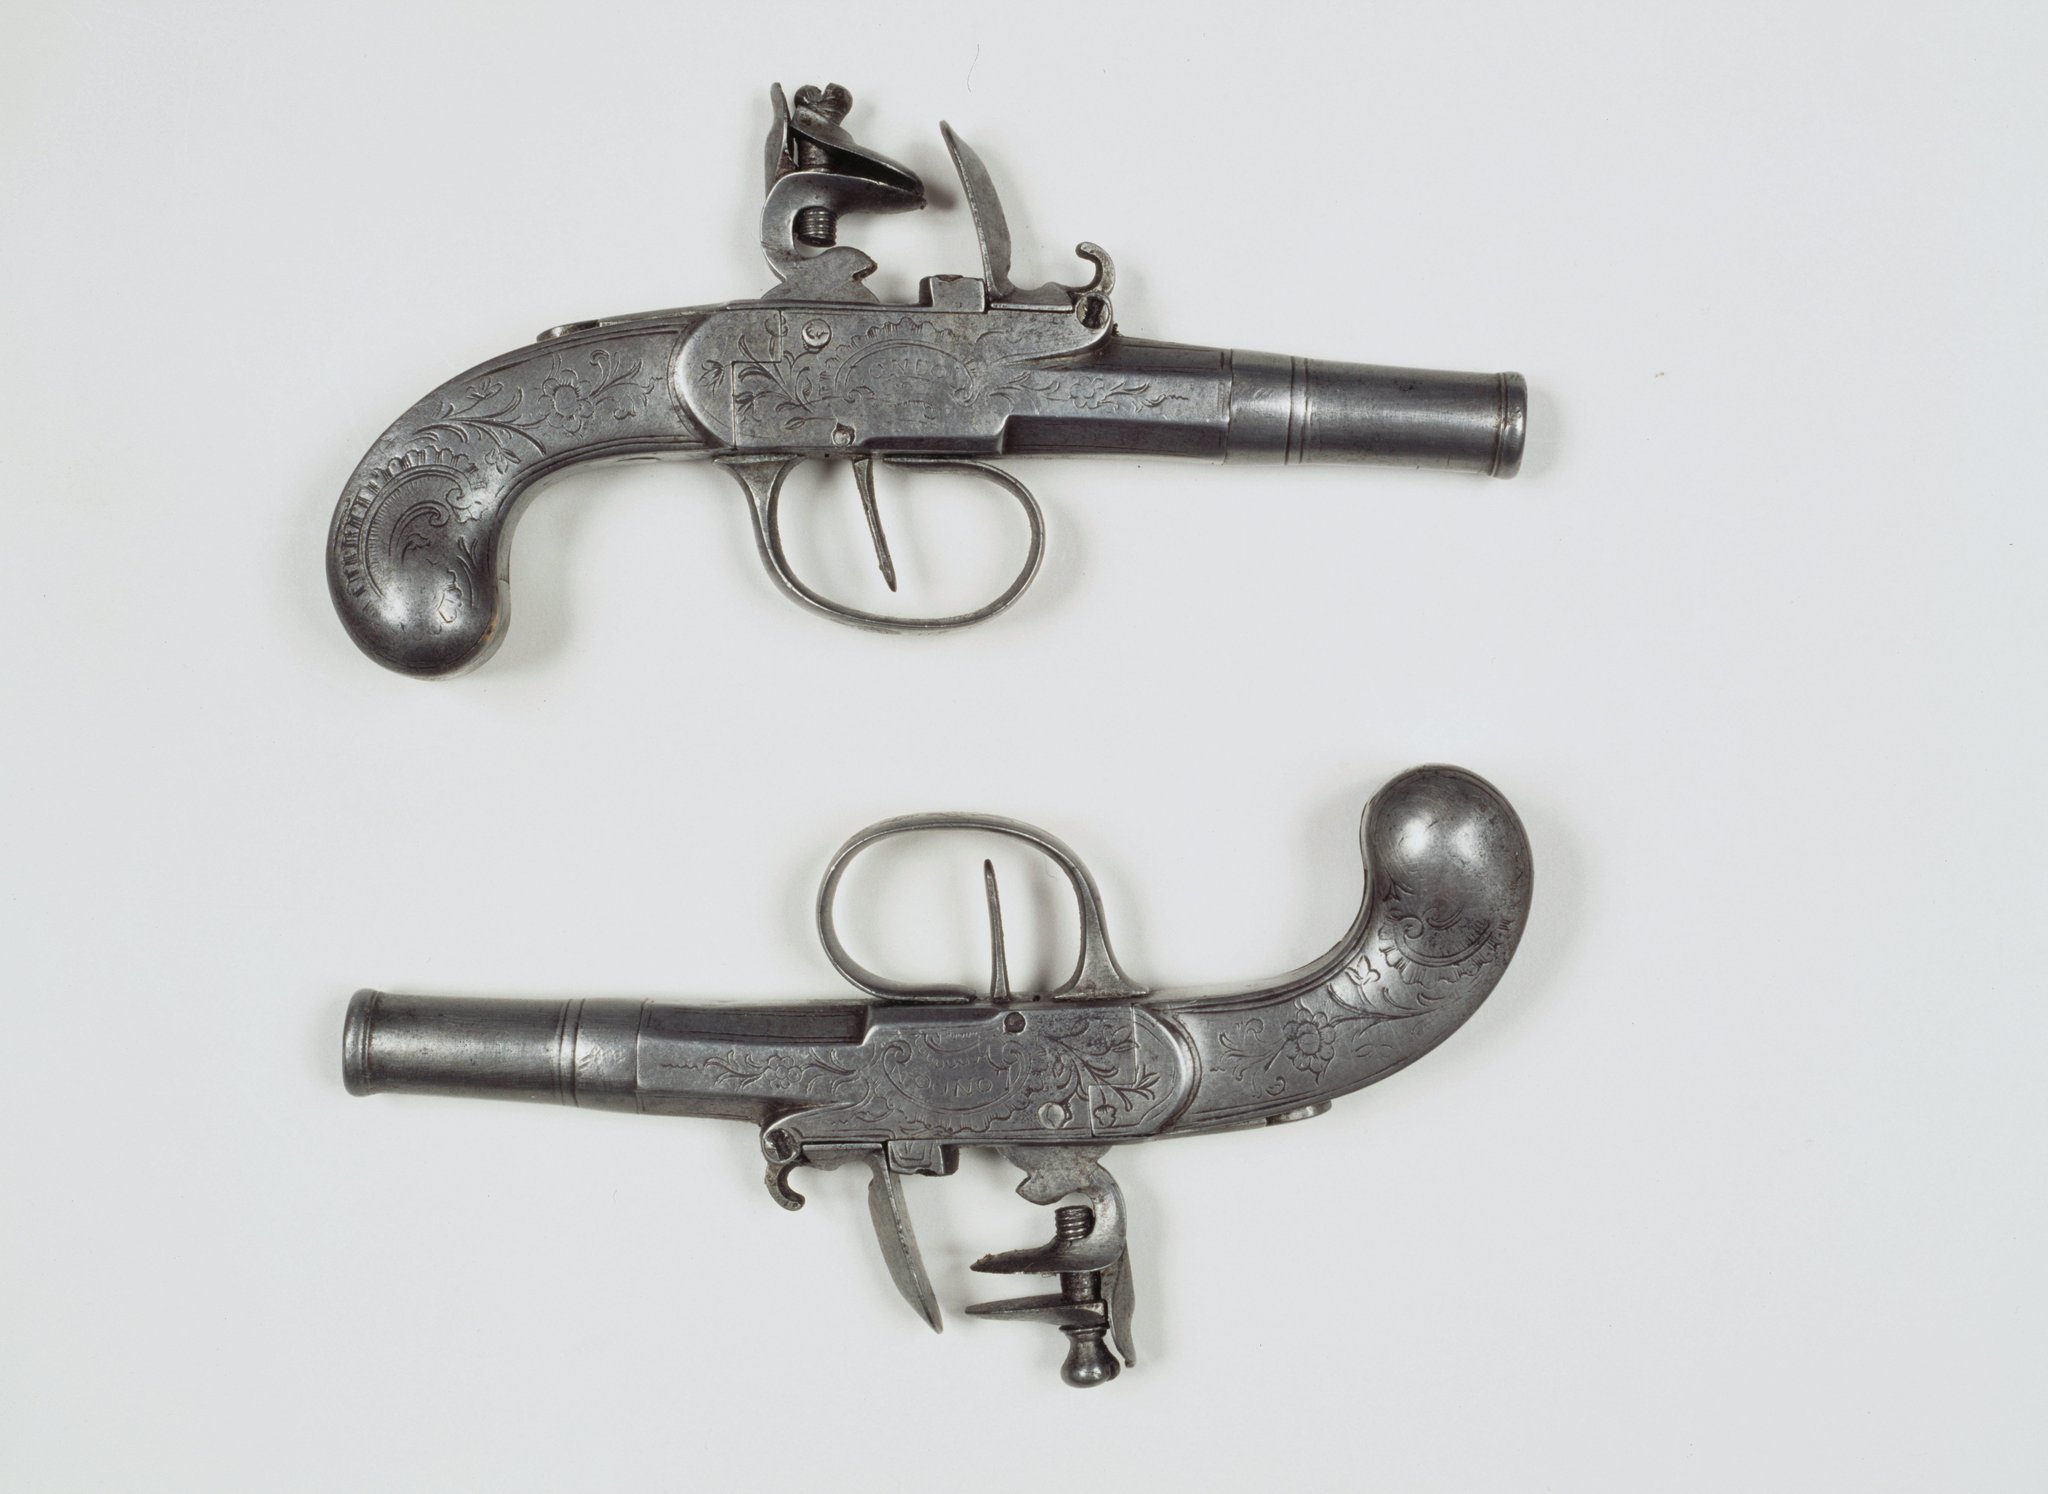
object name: pocket pistol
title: Zakpistool met vuursteenslot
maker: Anonymous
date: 1799-1899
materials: iron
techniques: engraving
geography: london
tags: netherlands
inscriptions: mark: ‘London’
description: Zakpistool met vuursteenslot, deel van koppel. Geheel van ijzer. Loopstrekken. Slotplaat beide zijden gemerkt: 'London'.